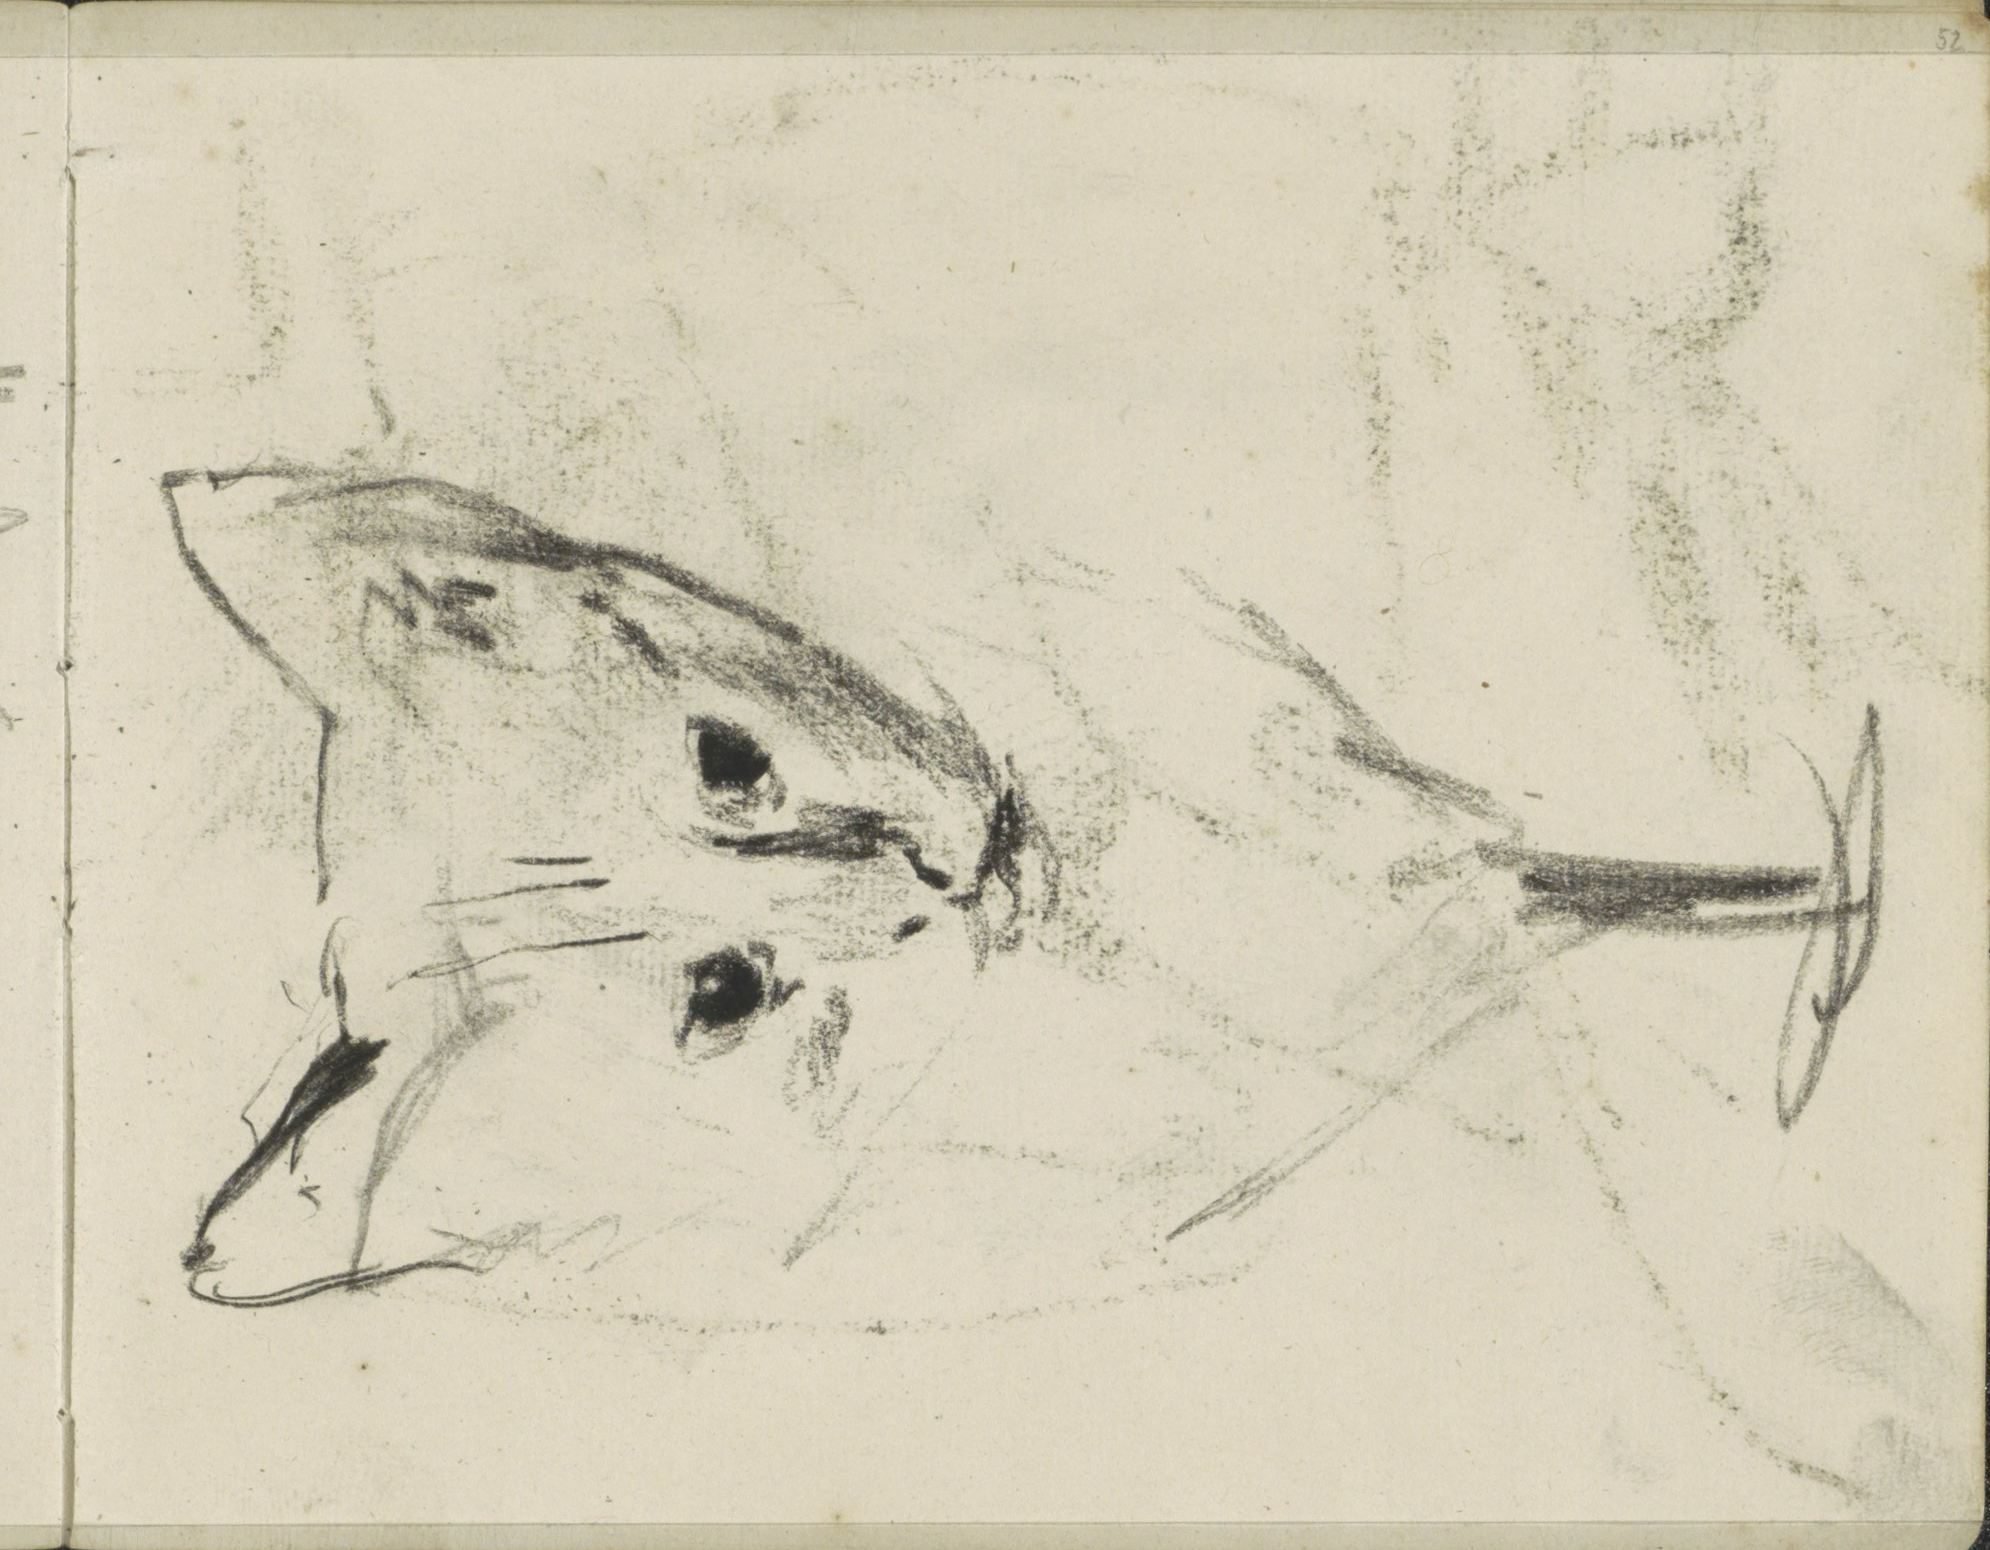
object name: sketchbook leaf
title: Kat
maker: george hendrik breitner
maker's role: draughtsman, painter, print maker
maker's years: 1857-1923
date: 1886-1903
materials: chalk, paper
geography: amsterdam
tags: cat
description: Pagina 52 uit een schetsboek met 27 bladen.